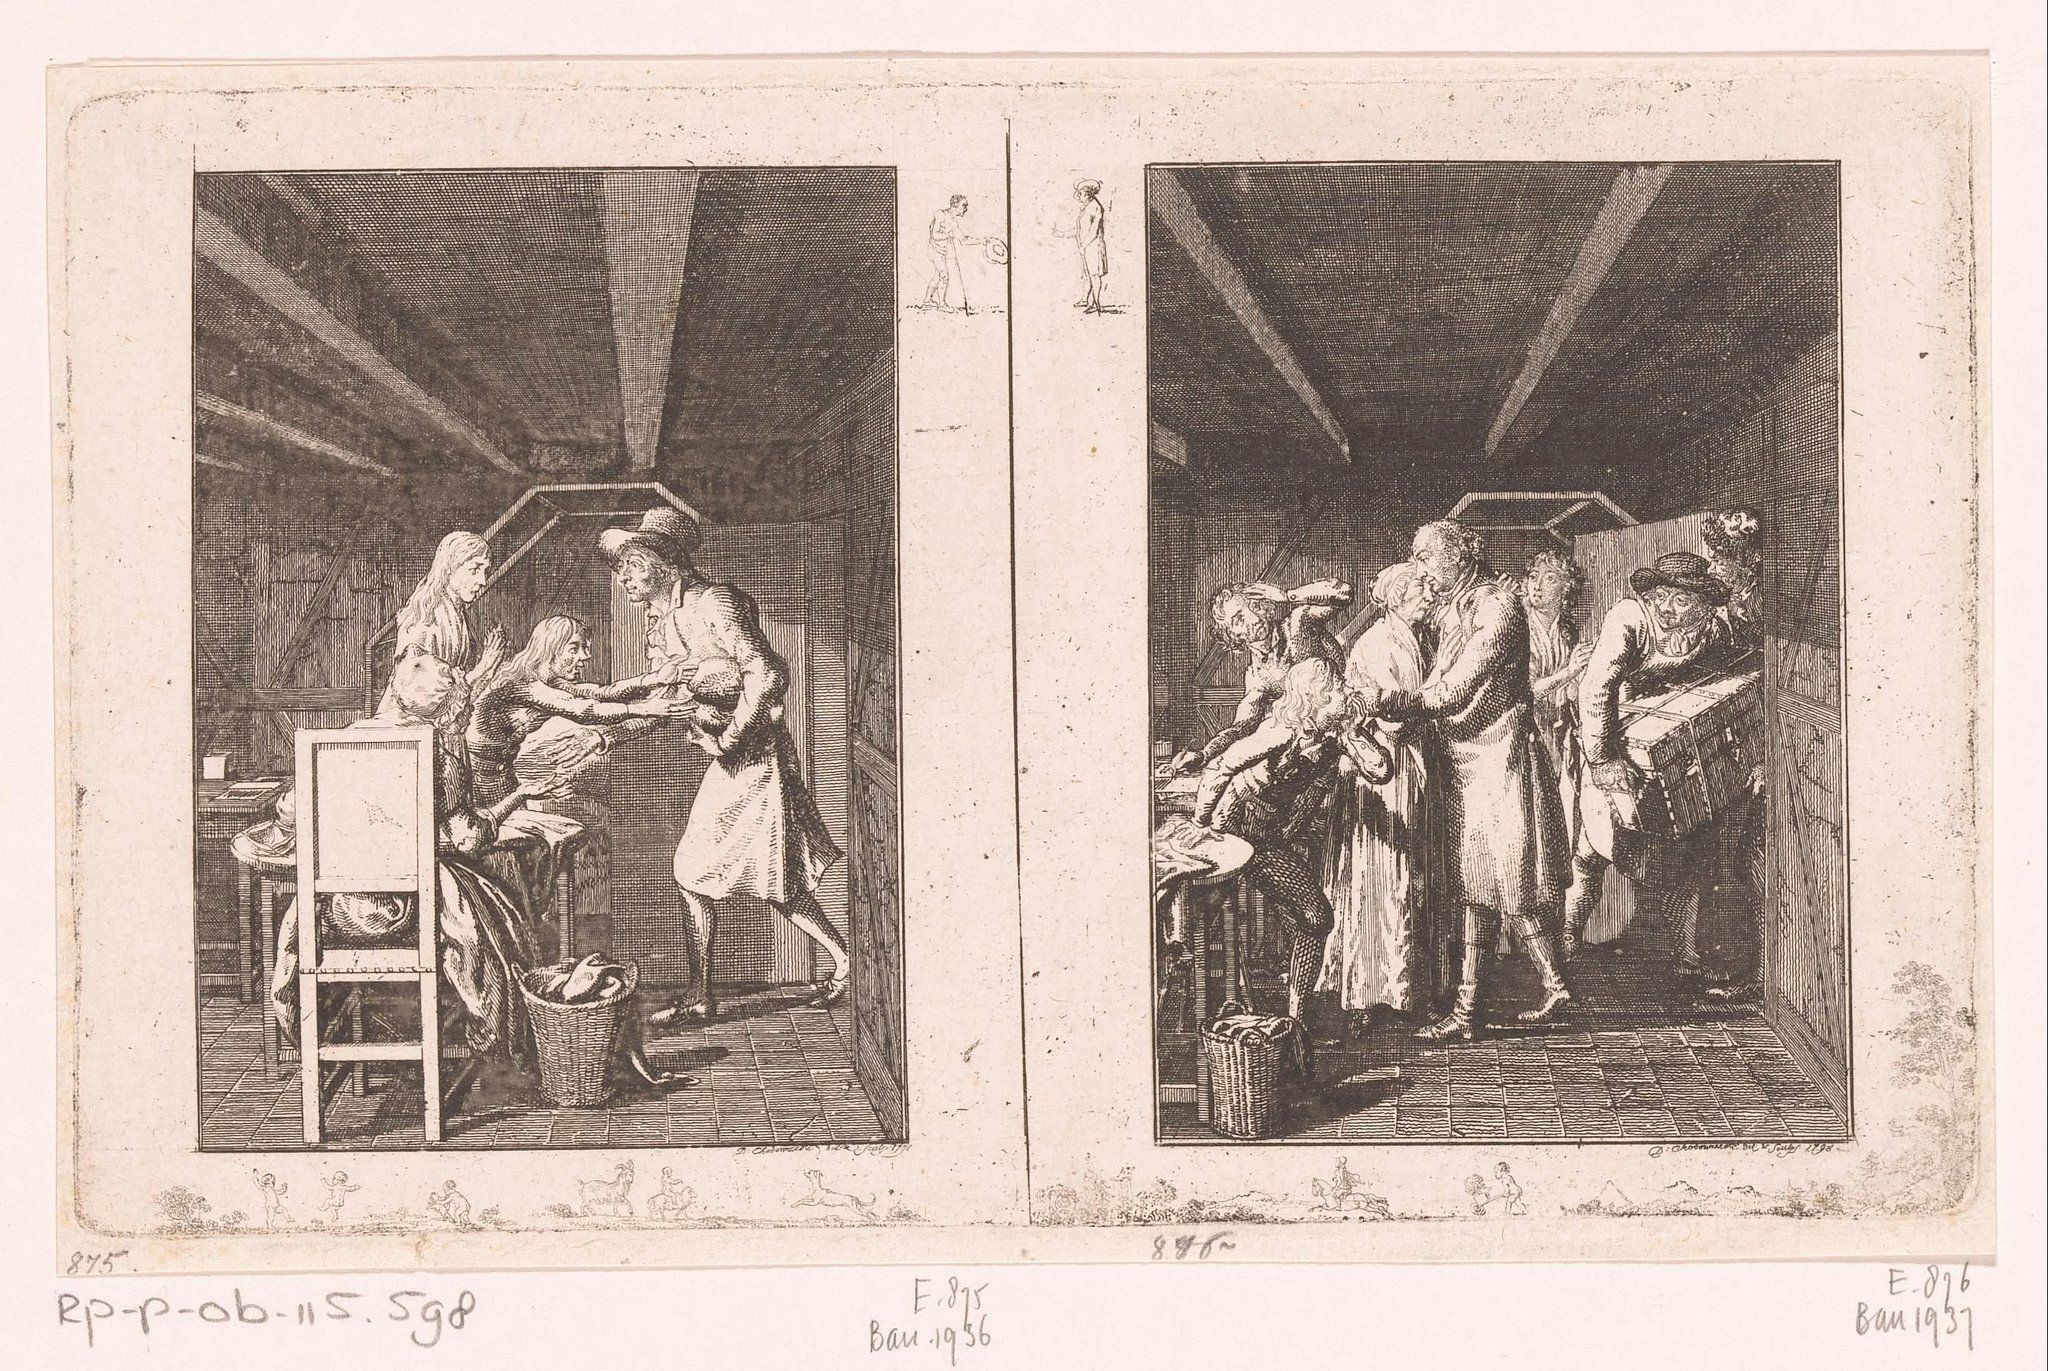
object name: print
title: Twee voorstellingen uit Familie Hellmuth van Hiemer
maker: daniel nikolaus chodowiecki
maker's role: draughtsman, print maker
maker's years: 1726-1801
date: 1798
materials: paper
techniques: etching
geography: berlin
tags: arrival and return ~ travelling, family, descendance, happiness, felicity, acquiring riches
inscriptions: collector's mark: Lugt 2228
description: Vervaardigd voor 'Familie Hellmuth' van Franz Karl Hiemer. Prent gebruikt voor: Tasschenbuch für Häusliche und Gesellschaftliche Freuden auf das Jahr 1799, 1801 und 1802 (...). Frankfurt am Main: Philipp Heinrich Guilhauman, [1797].